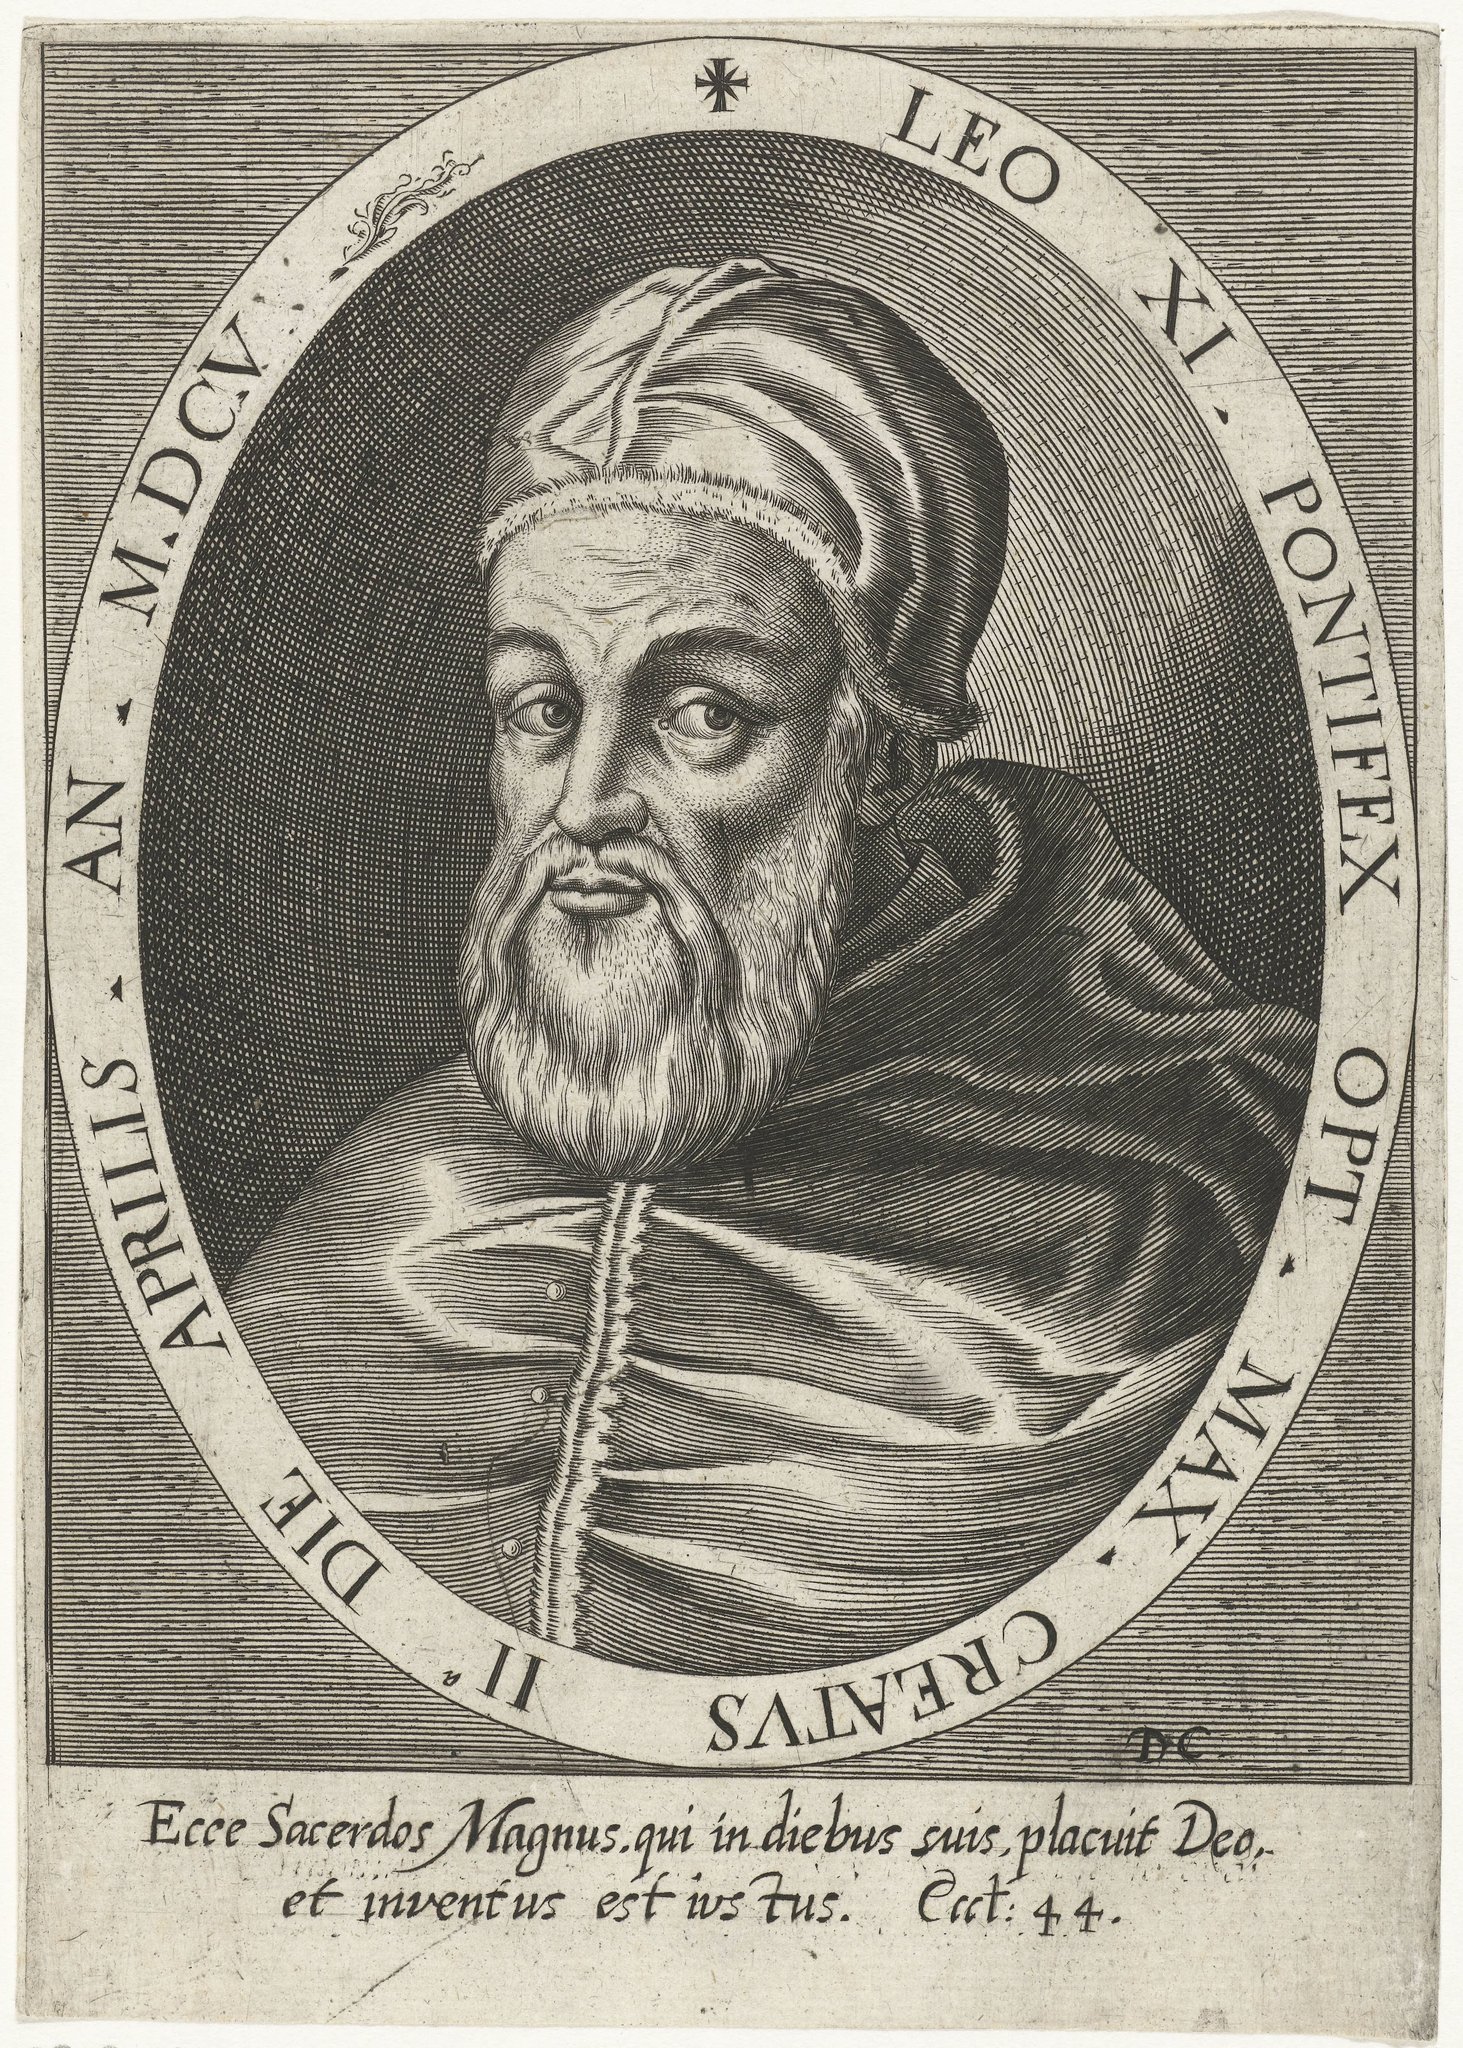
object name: print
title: Portret van paus Leo XI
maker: dominicus custos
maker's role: print maker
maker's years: 1560-1615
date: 1605-1606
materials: paper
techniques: engraving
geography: augsburg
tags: leo xi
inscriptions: collector's mark: Lugt 2228